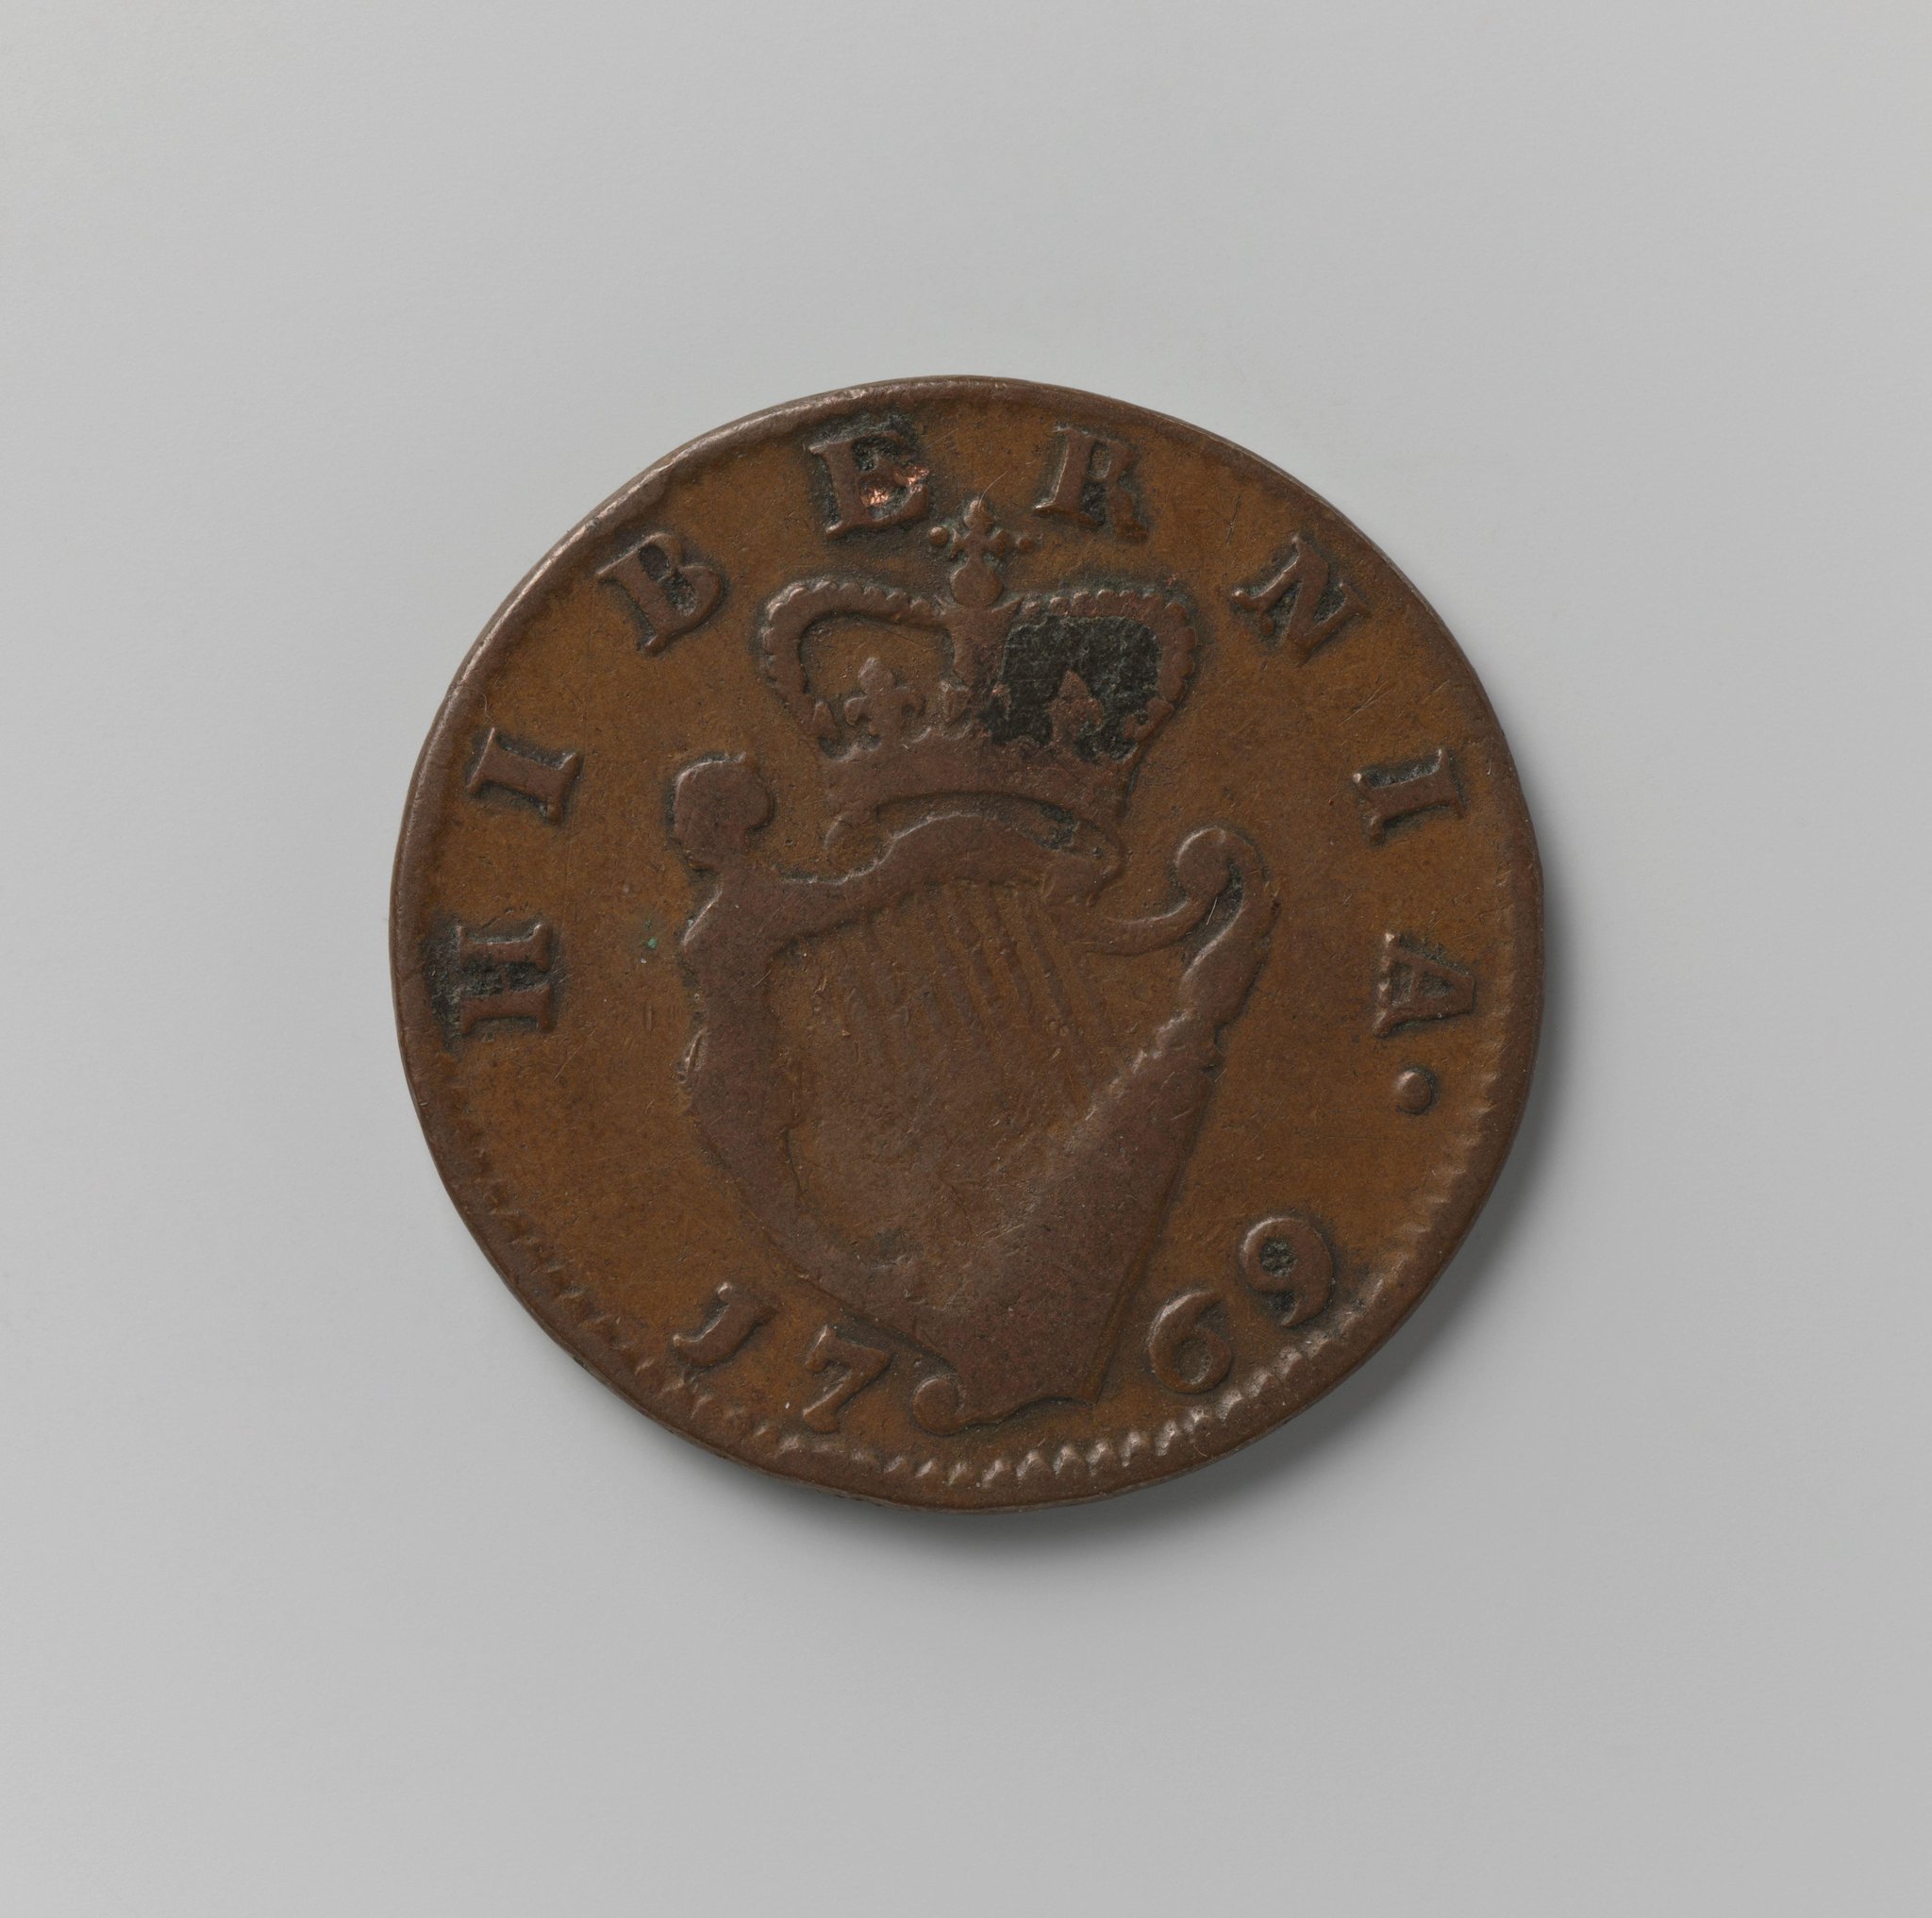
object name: coin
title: ½ penny uit Ierland van George III, 1769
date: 1769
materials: copper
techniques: striking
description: Koperen munt. Voorzijde: gelauwerd hoofd van de vorst naar rechts. Keerzijde: tussen jaartal in omschrift gekroonde harp. Gladde rand.